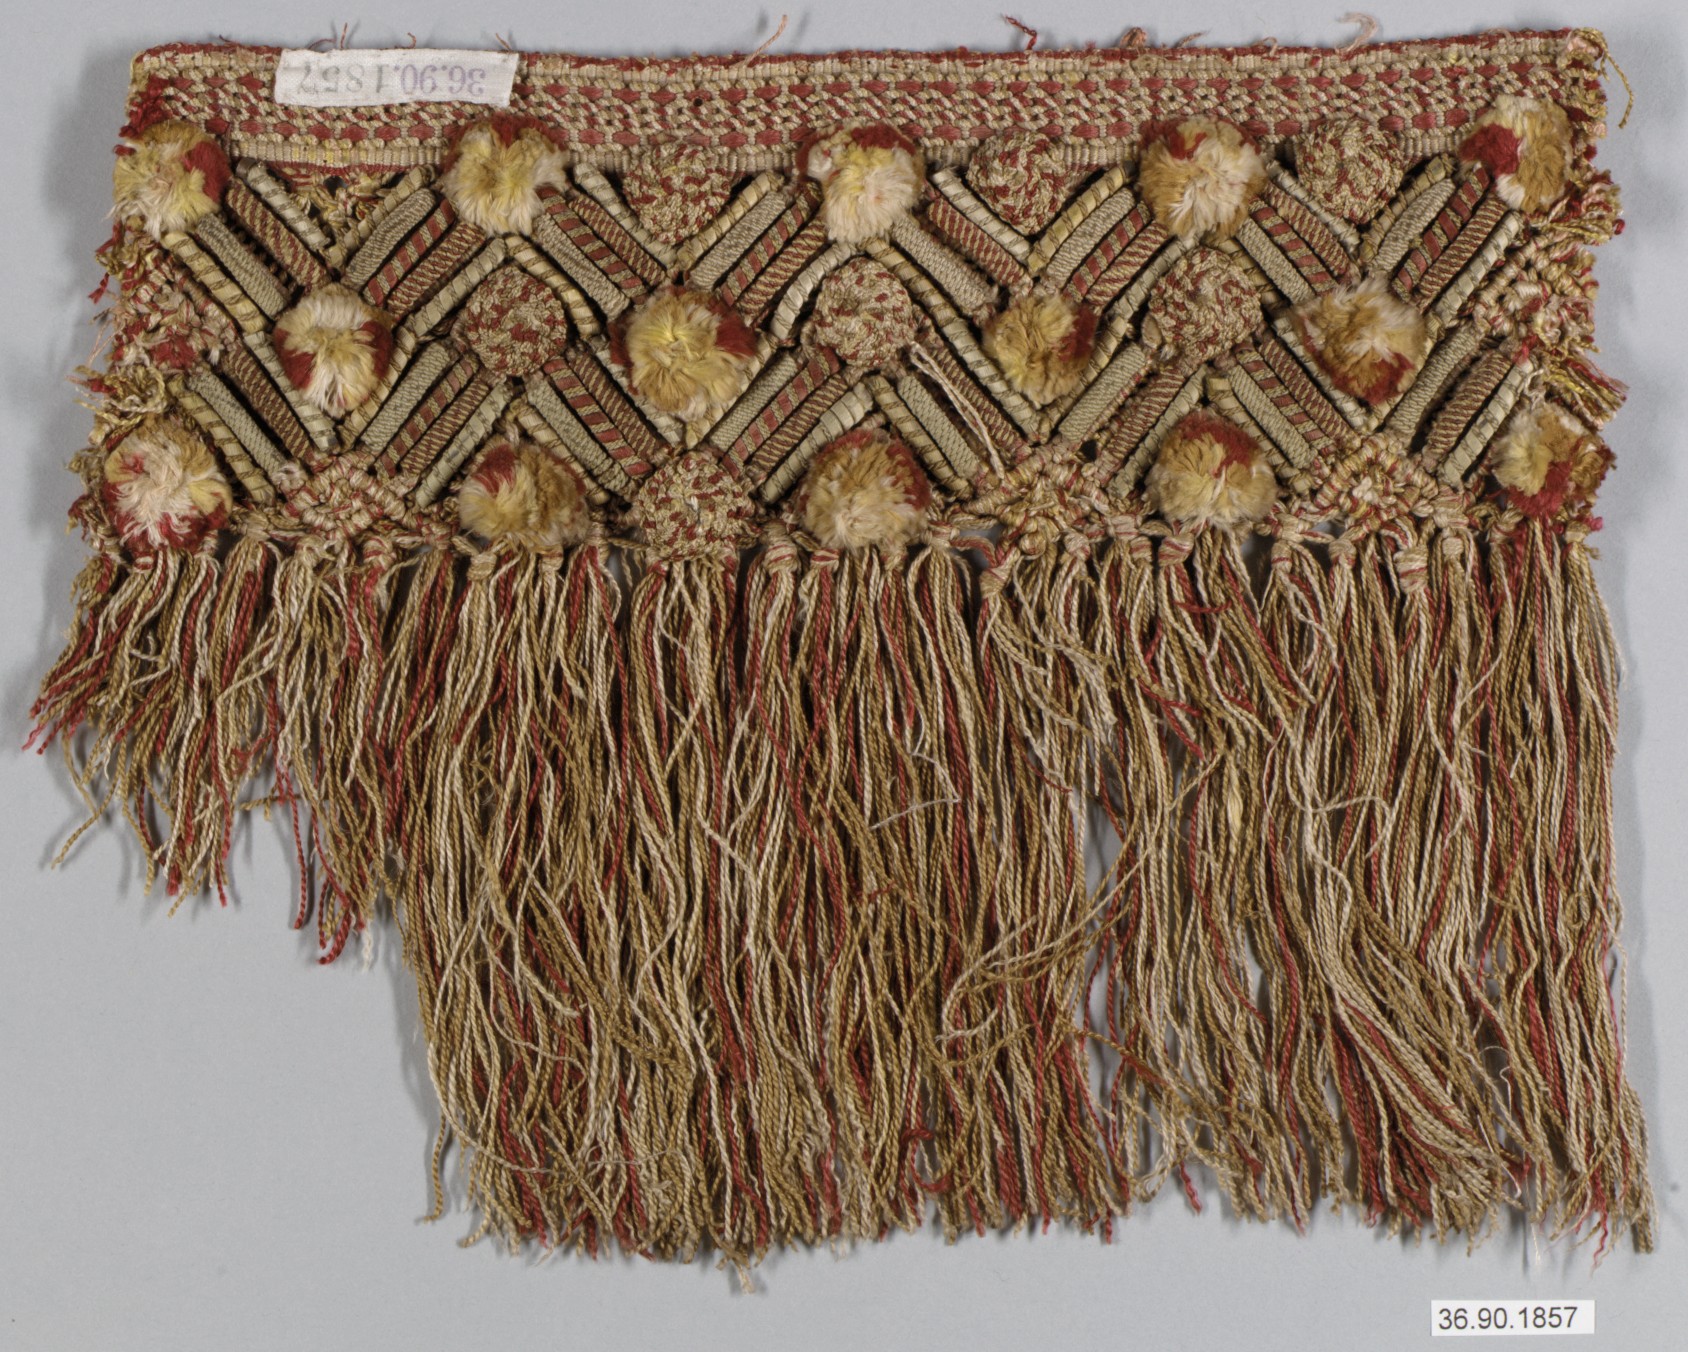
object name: fringe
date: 1701-1800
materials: silk